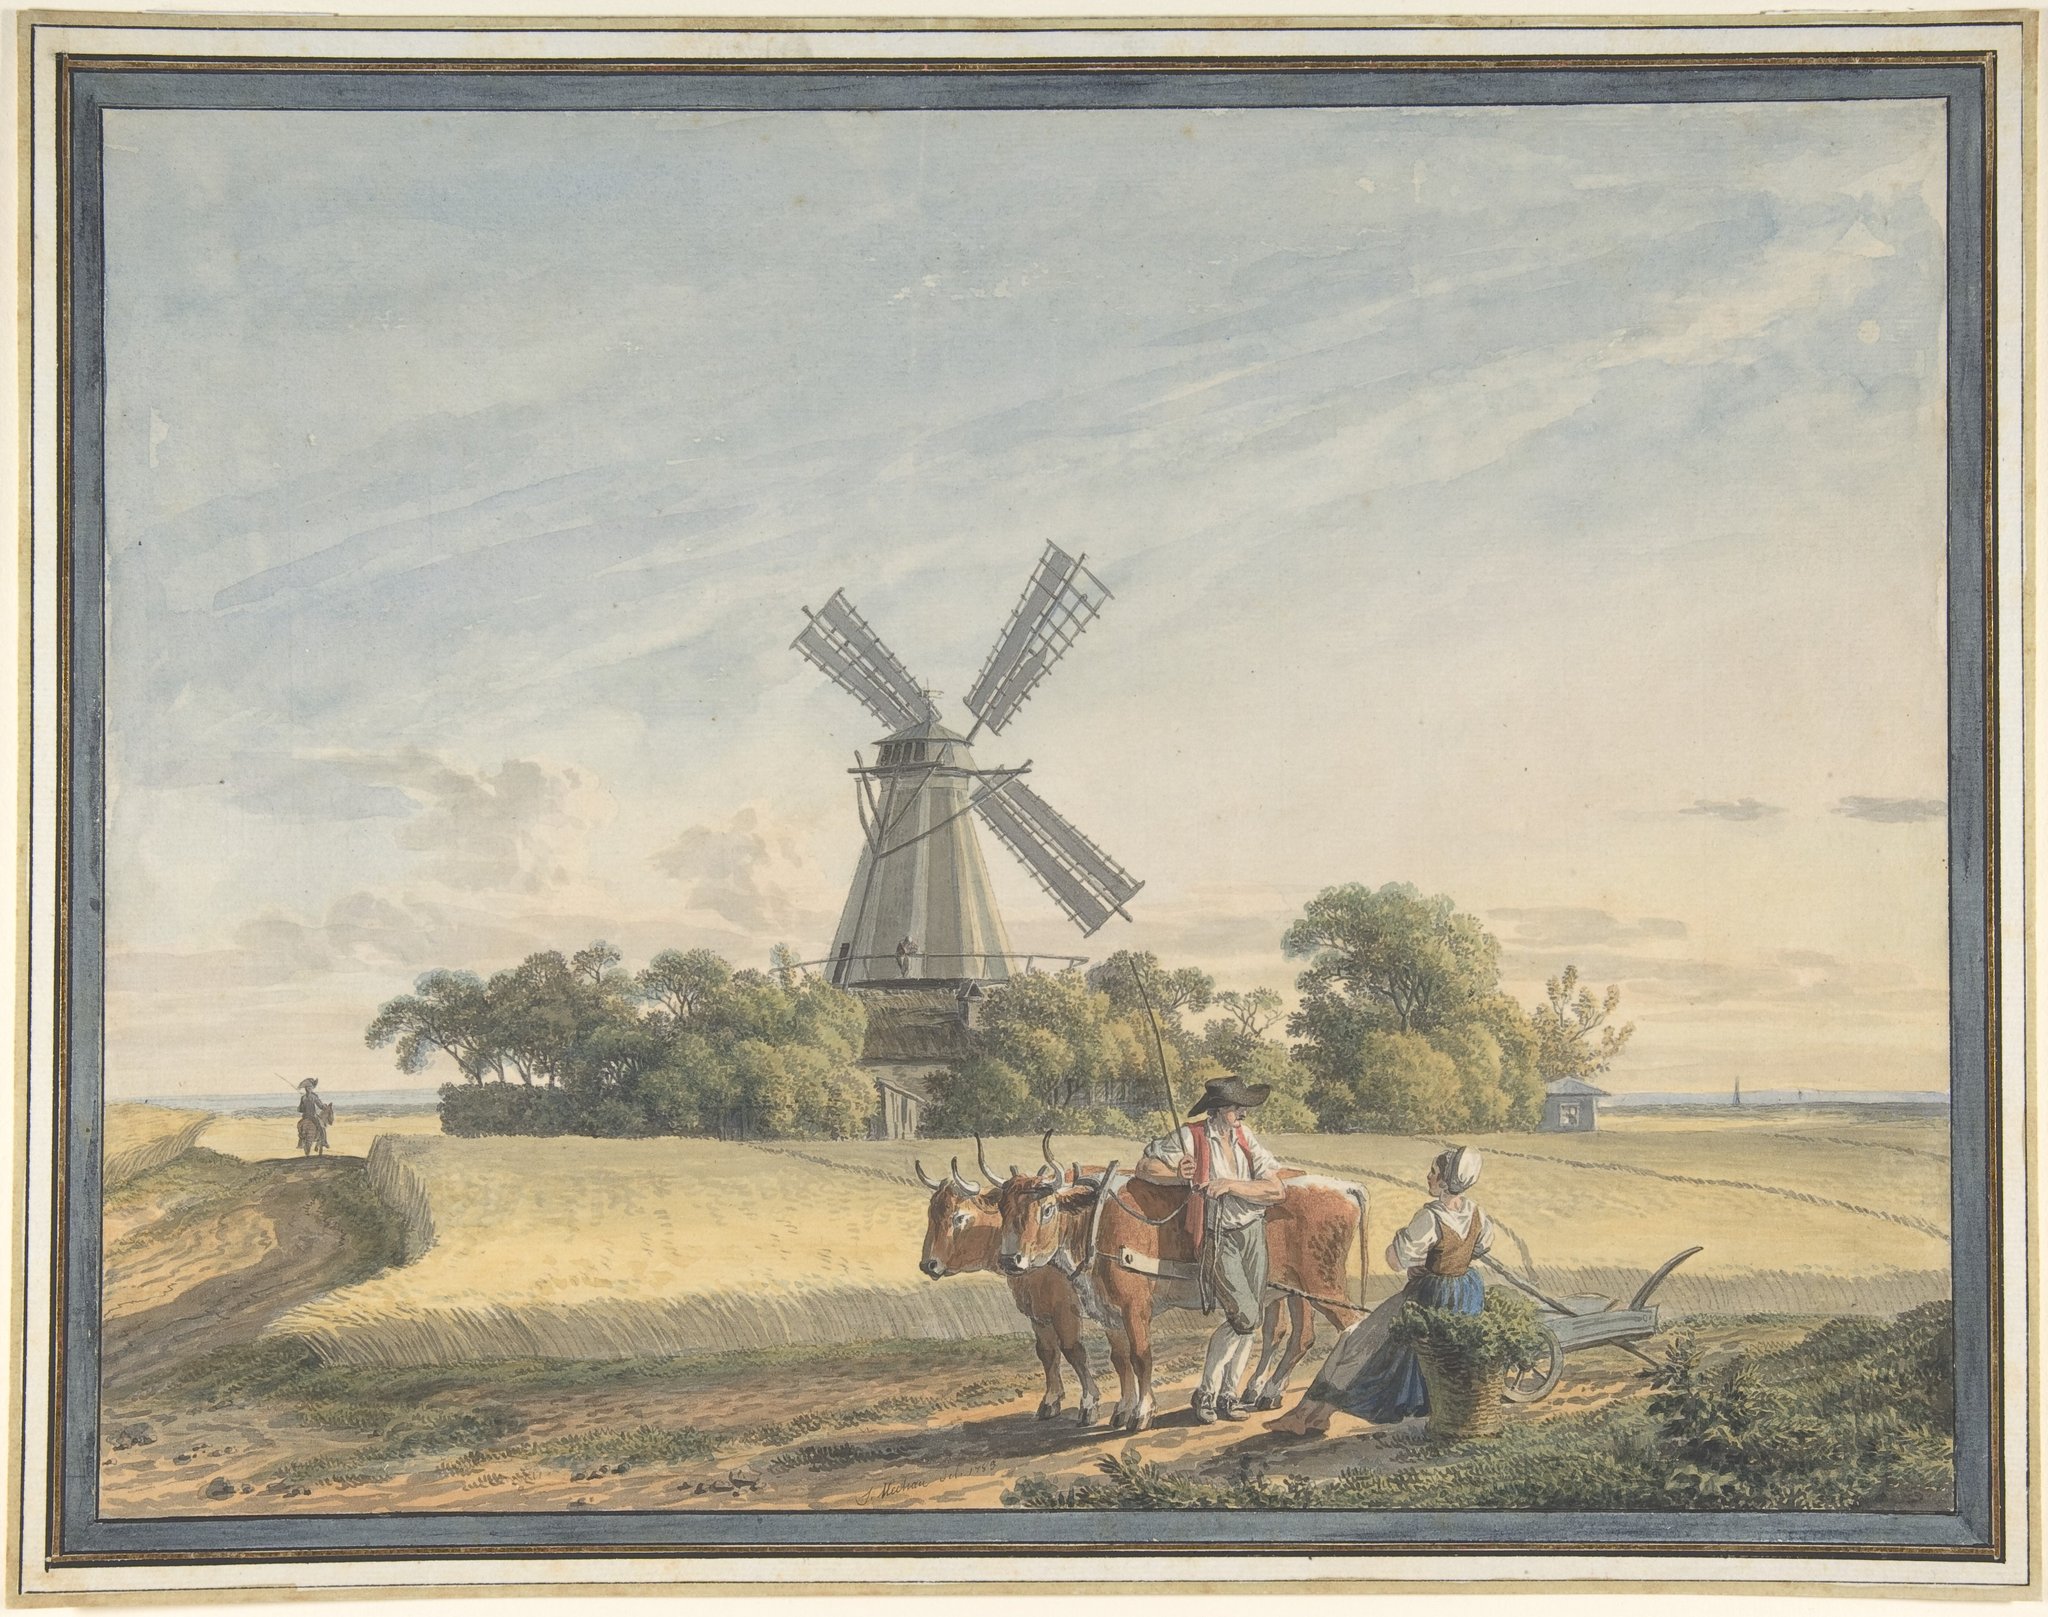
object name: drawing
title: Landscape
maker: jacob wilhelm mechau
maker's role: artist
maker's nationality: german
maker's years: 1745-1808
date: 1785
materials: graphite, ink, watercolor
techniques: pen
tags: windmills,cows,landscapes